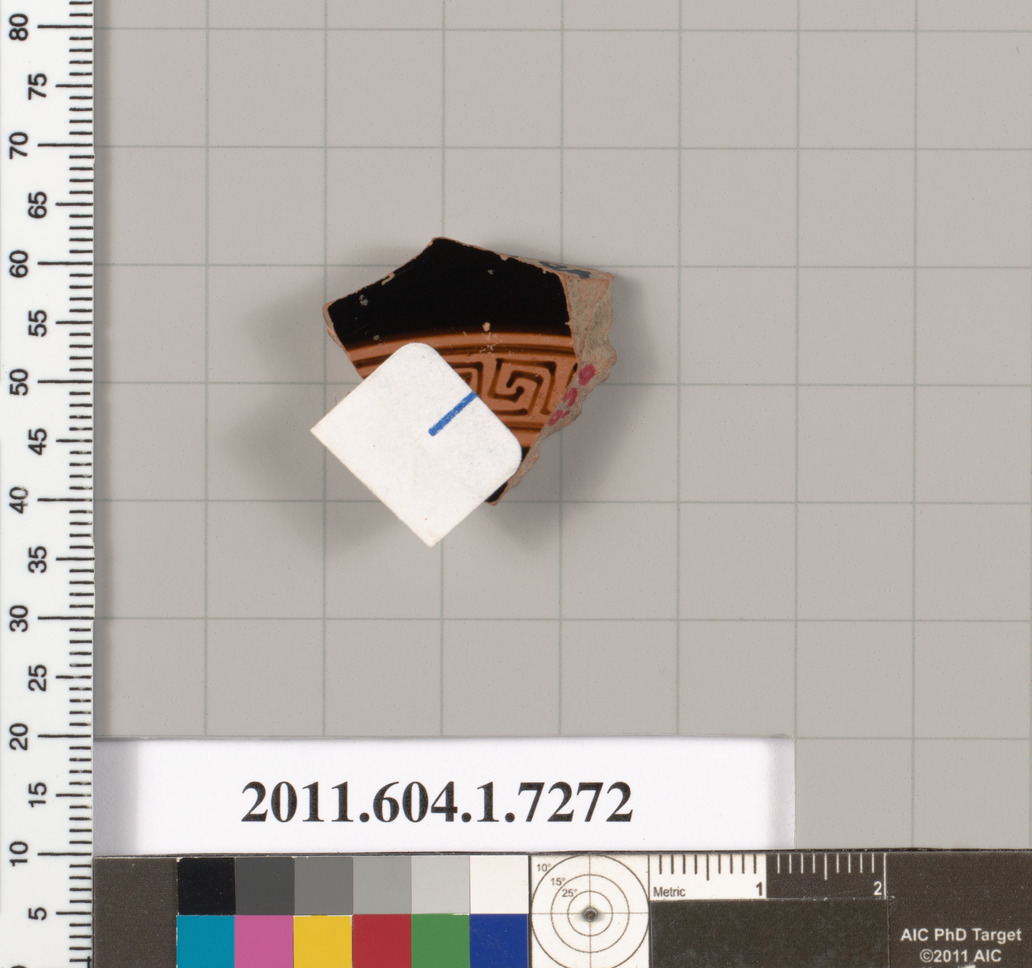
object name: kylix fragment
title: Terracotta fragment of a kylix (drinking cup)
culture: greek, attic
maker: makron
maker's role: artist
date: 500-480 BCE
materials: terracotta